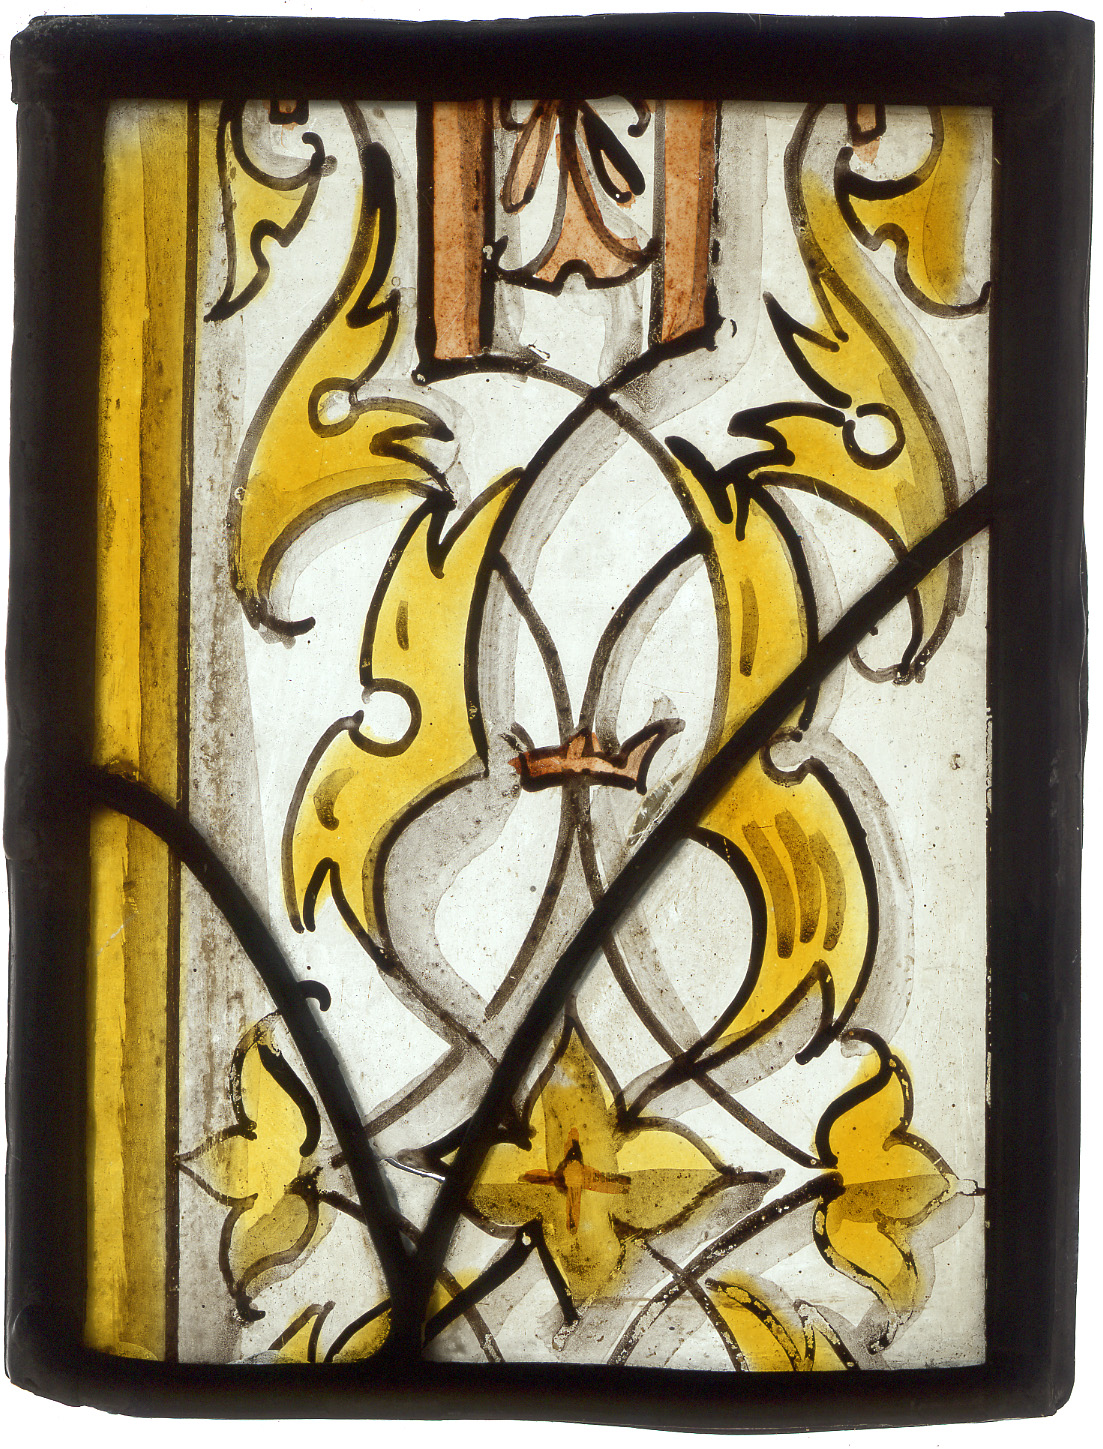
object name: border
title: Border fragment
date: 1801-1900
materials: glass, lead, paint, pigment